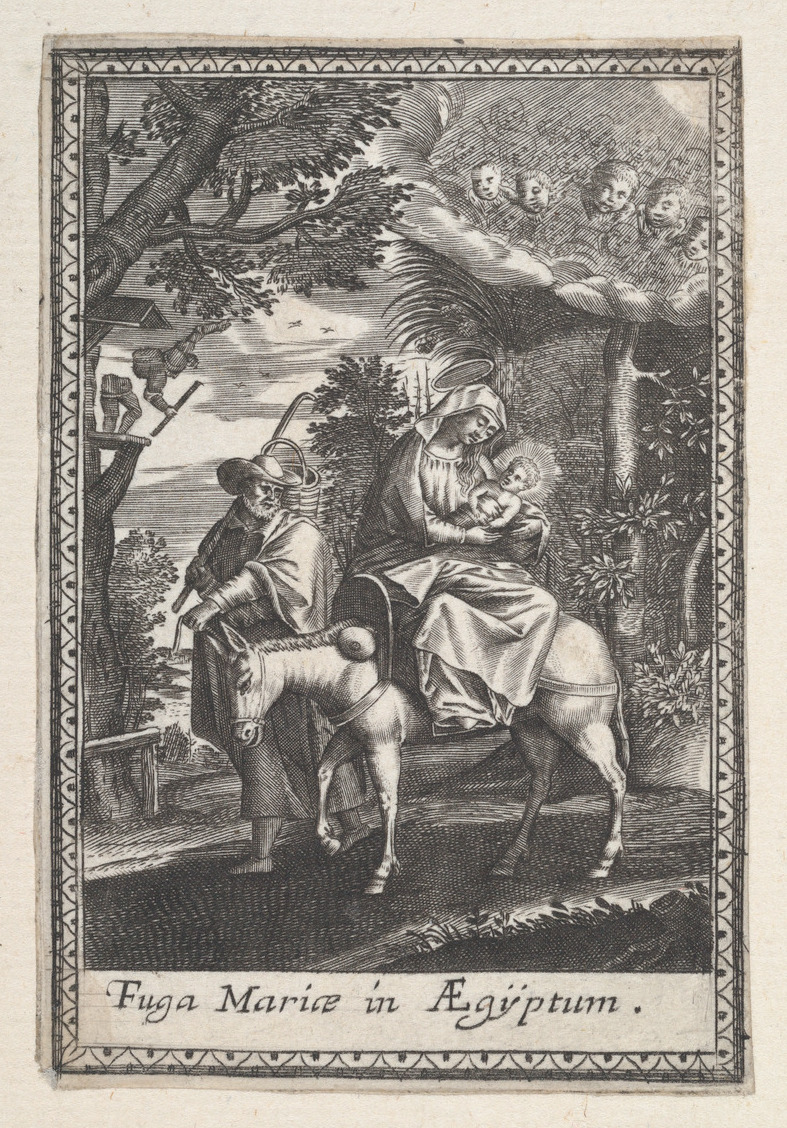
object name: print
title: The Flight into Egypt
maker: Anonymous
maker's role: artist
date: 1590-1620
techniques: engraving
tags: donkeys,madonna and child,saints